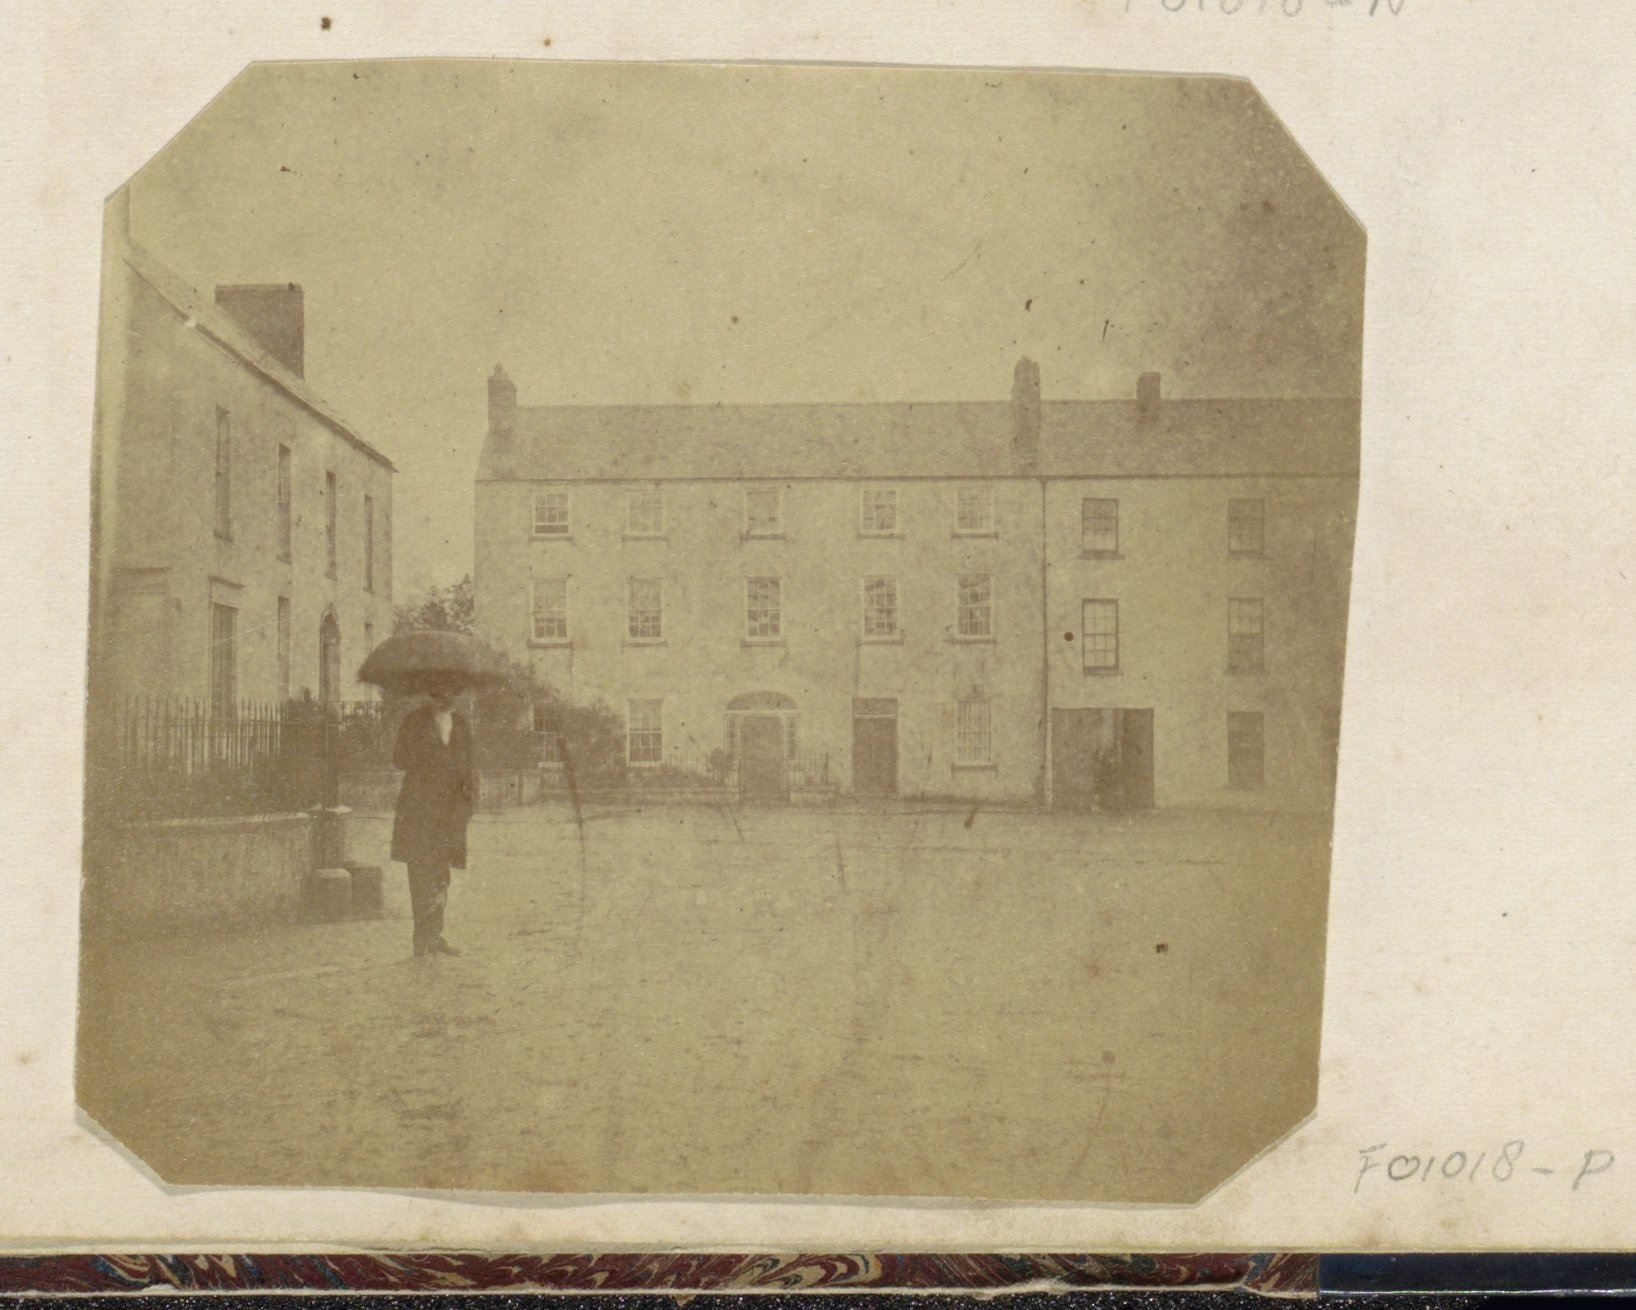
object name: photograph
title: Man met een paraplu staand voor huizen, vermoedelijk in Birr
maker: Anonymous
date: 1860-1870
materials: paper, photographic support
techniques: albumen print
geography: birr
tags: umbrella, square, place, circus, etc. (+ city(-scape) with figures, staffage)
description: Onderdeel van Engels familiealbum met foto's van personen, reizen, cricket en kunstwerken.